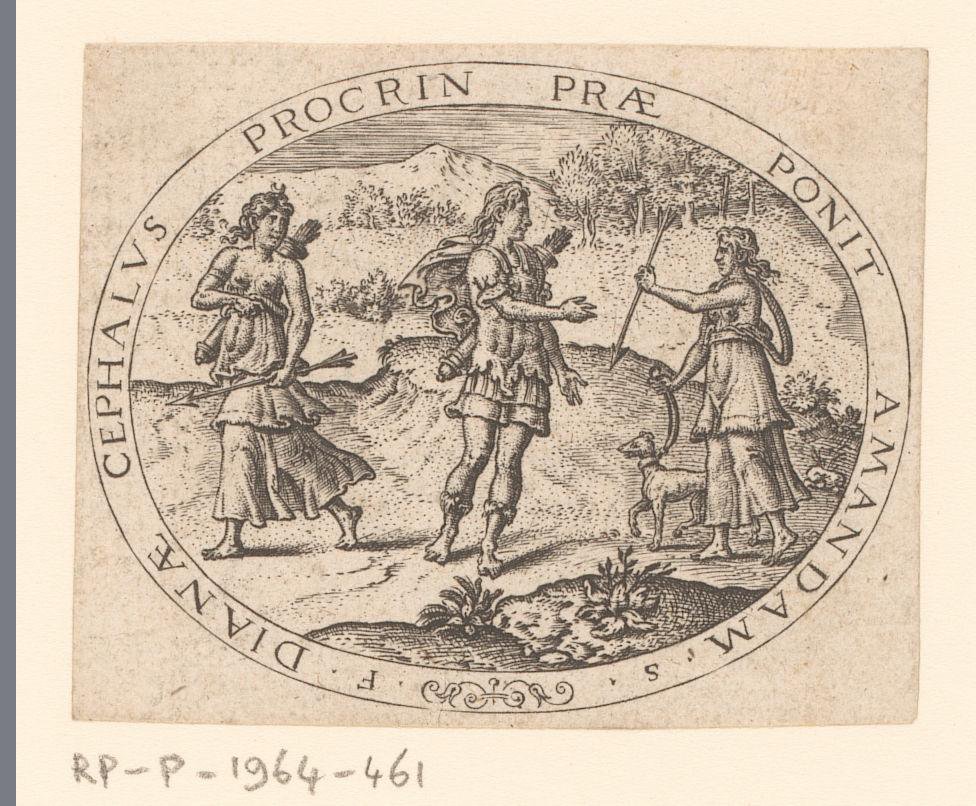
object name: print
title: Cephalus en Procris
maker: etienne delaune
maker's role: draughtsman, goldsmith, print maker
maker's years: 1519-1583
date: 1528-1583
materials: paper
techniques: engraving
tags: cephalus and procris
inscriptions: collector's mark: Lugt 2228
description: Maakt deel uit van een twaalfdelige serie met mythologische scènes in ovale omlijstingen.